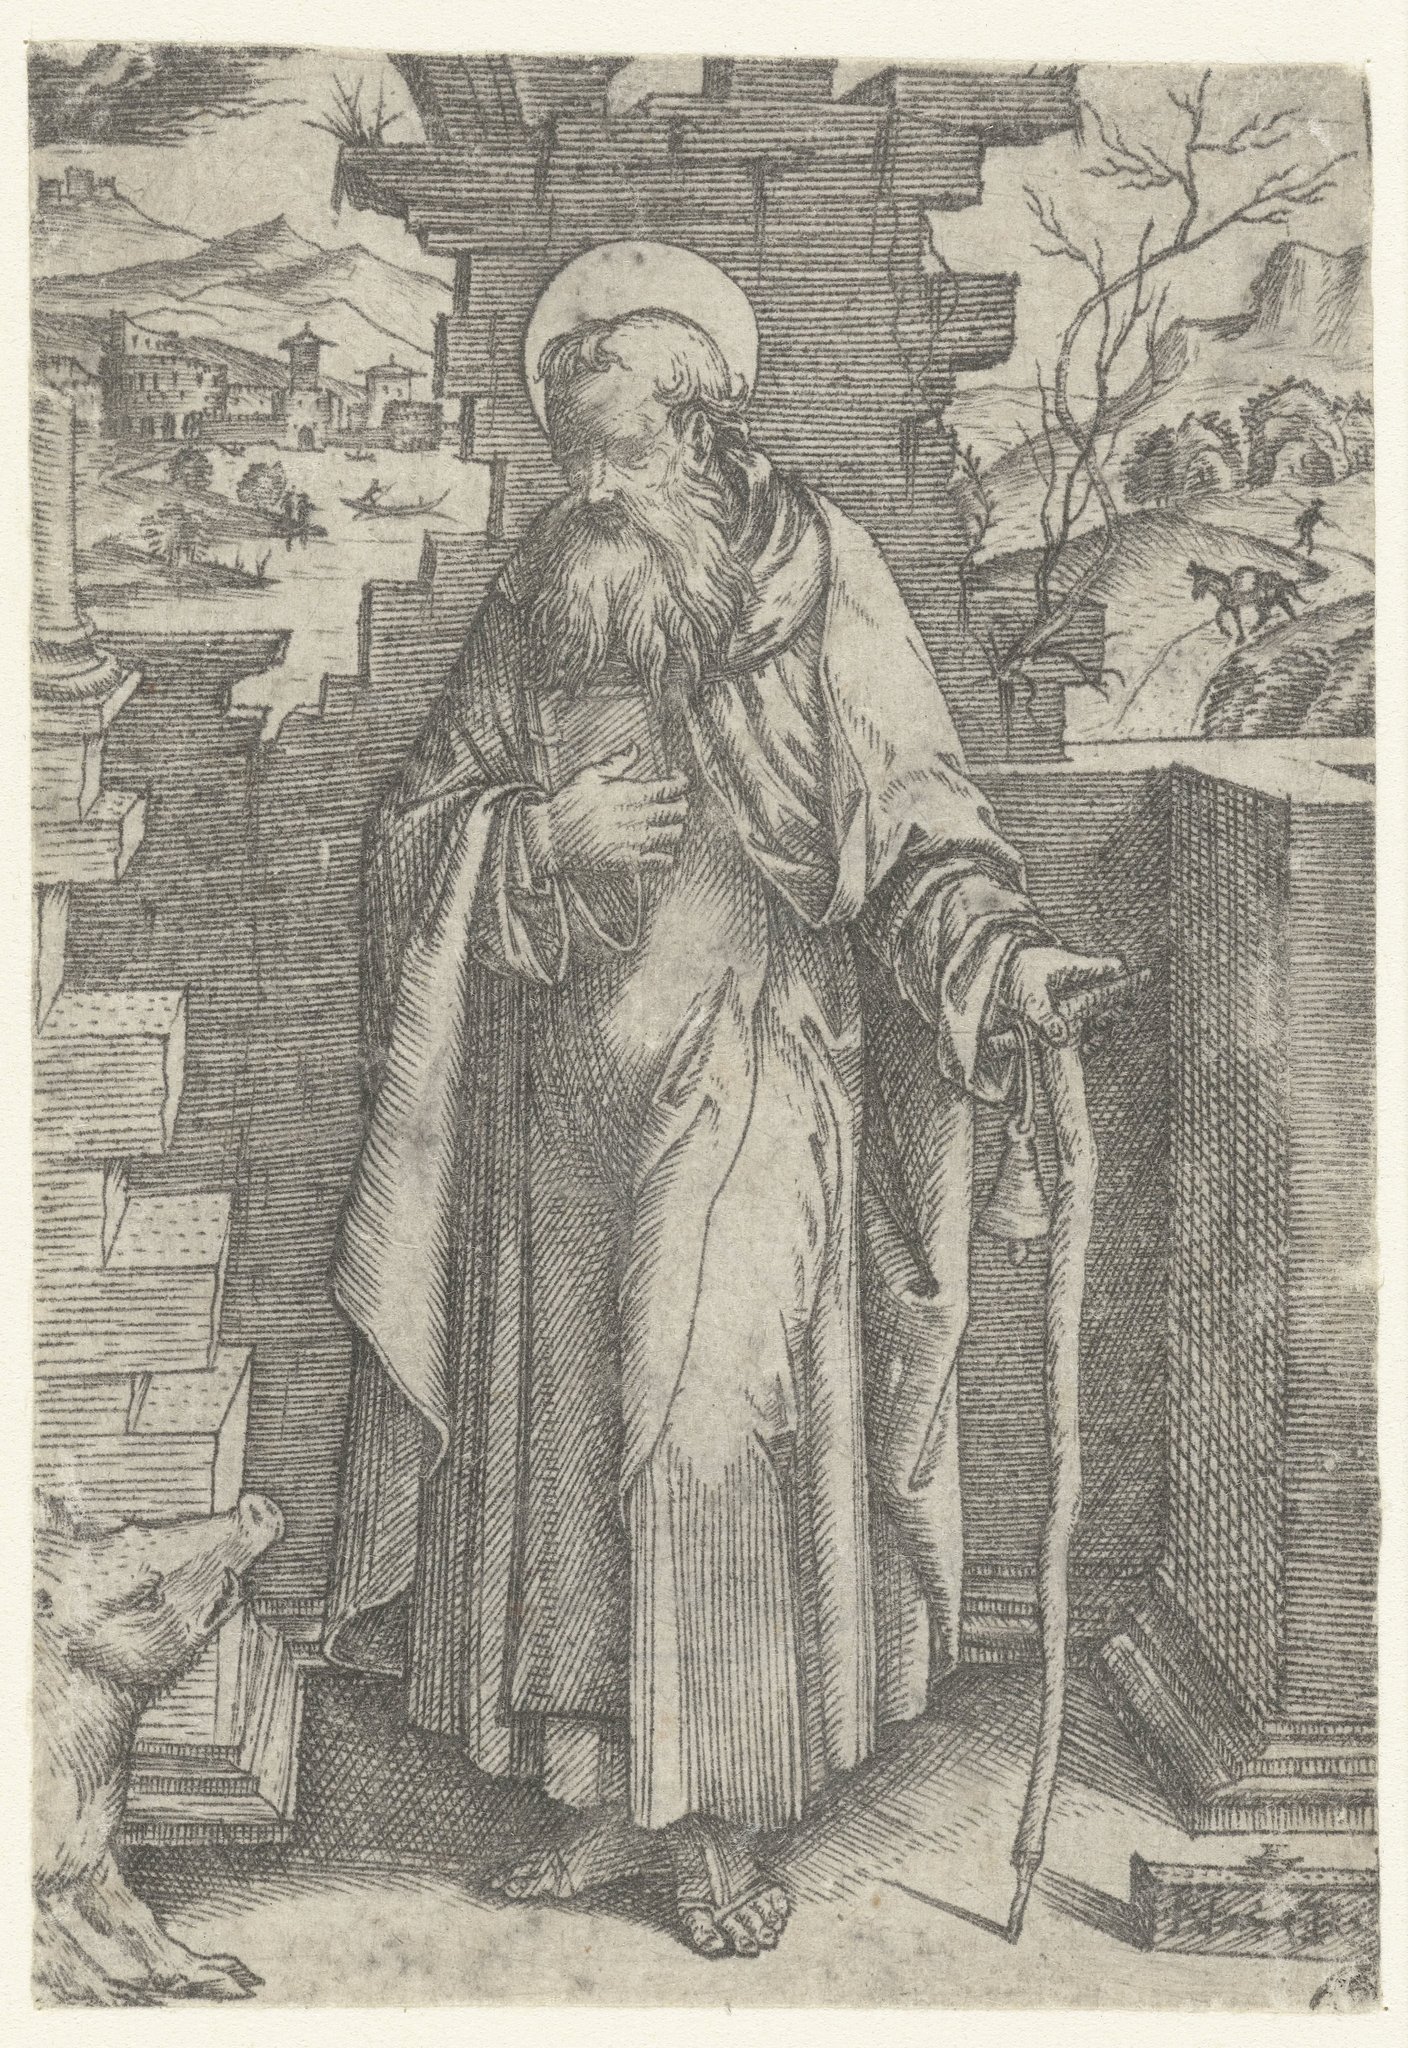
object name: print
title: Heilige Antonius de Grote met taukruis en varken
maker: nicoletto da modena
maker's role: print maker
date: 1510-1520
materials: paper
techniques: engraving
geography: italy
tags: personal devotion of st. antony abbot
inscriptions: collector's mark: Lugt 2228, collector's mark: Lugt 2760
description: Twee exemplaren bekend, andere prent met herkomst collectie Friedrich August von Sachsen wordt in Dresden bewaard. De figuur van de heilige kopieerde de kunstenaar in spiegelbeeld naar een prent van Marcantonio Raimondi, de achtergrond gaf hij echter een geheel eigen invulling (zie documentatie).